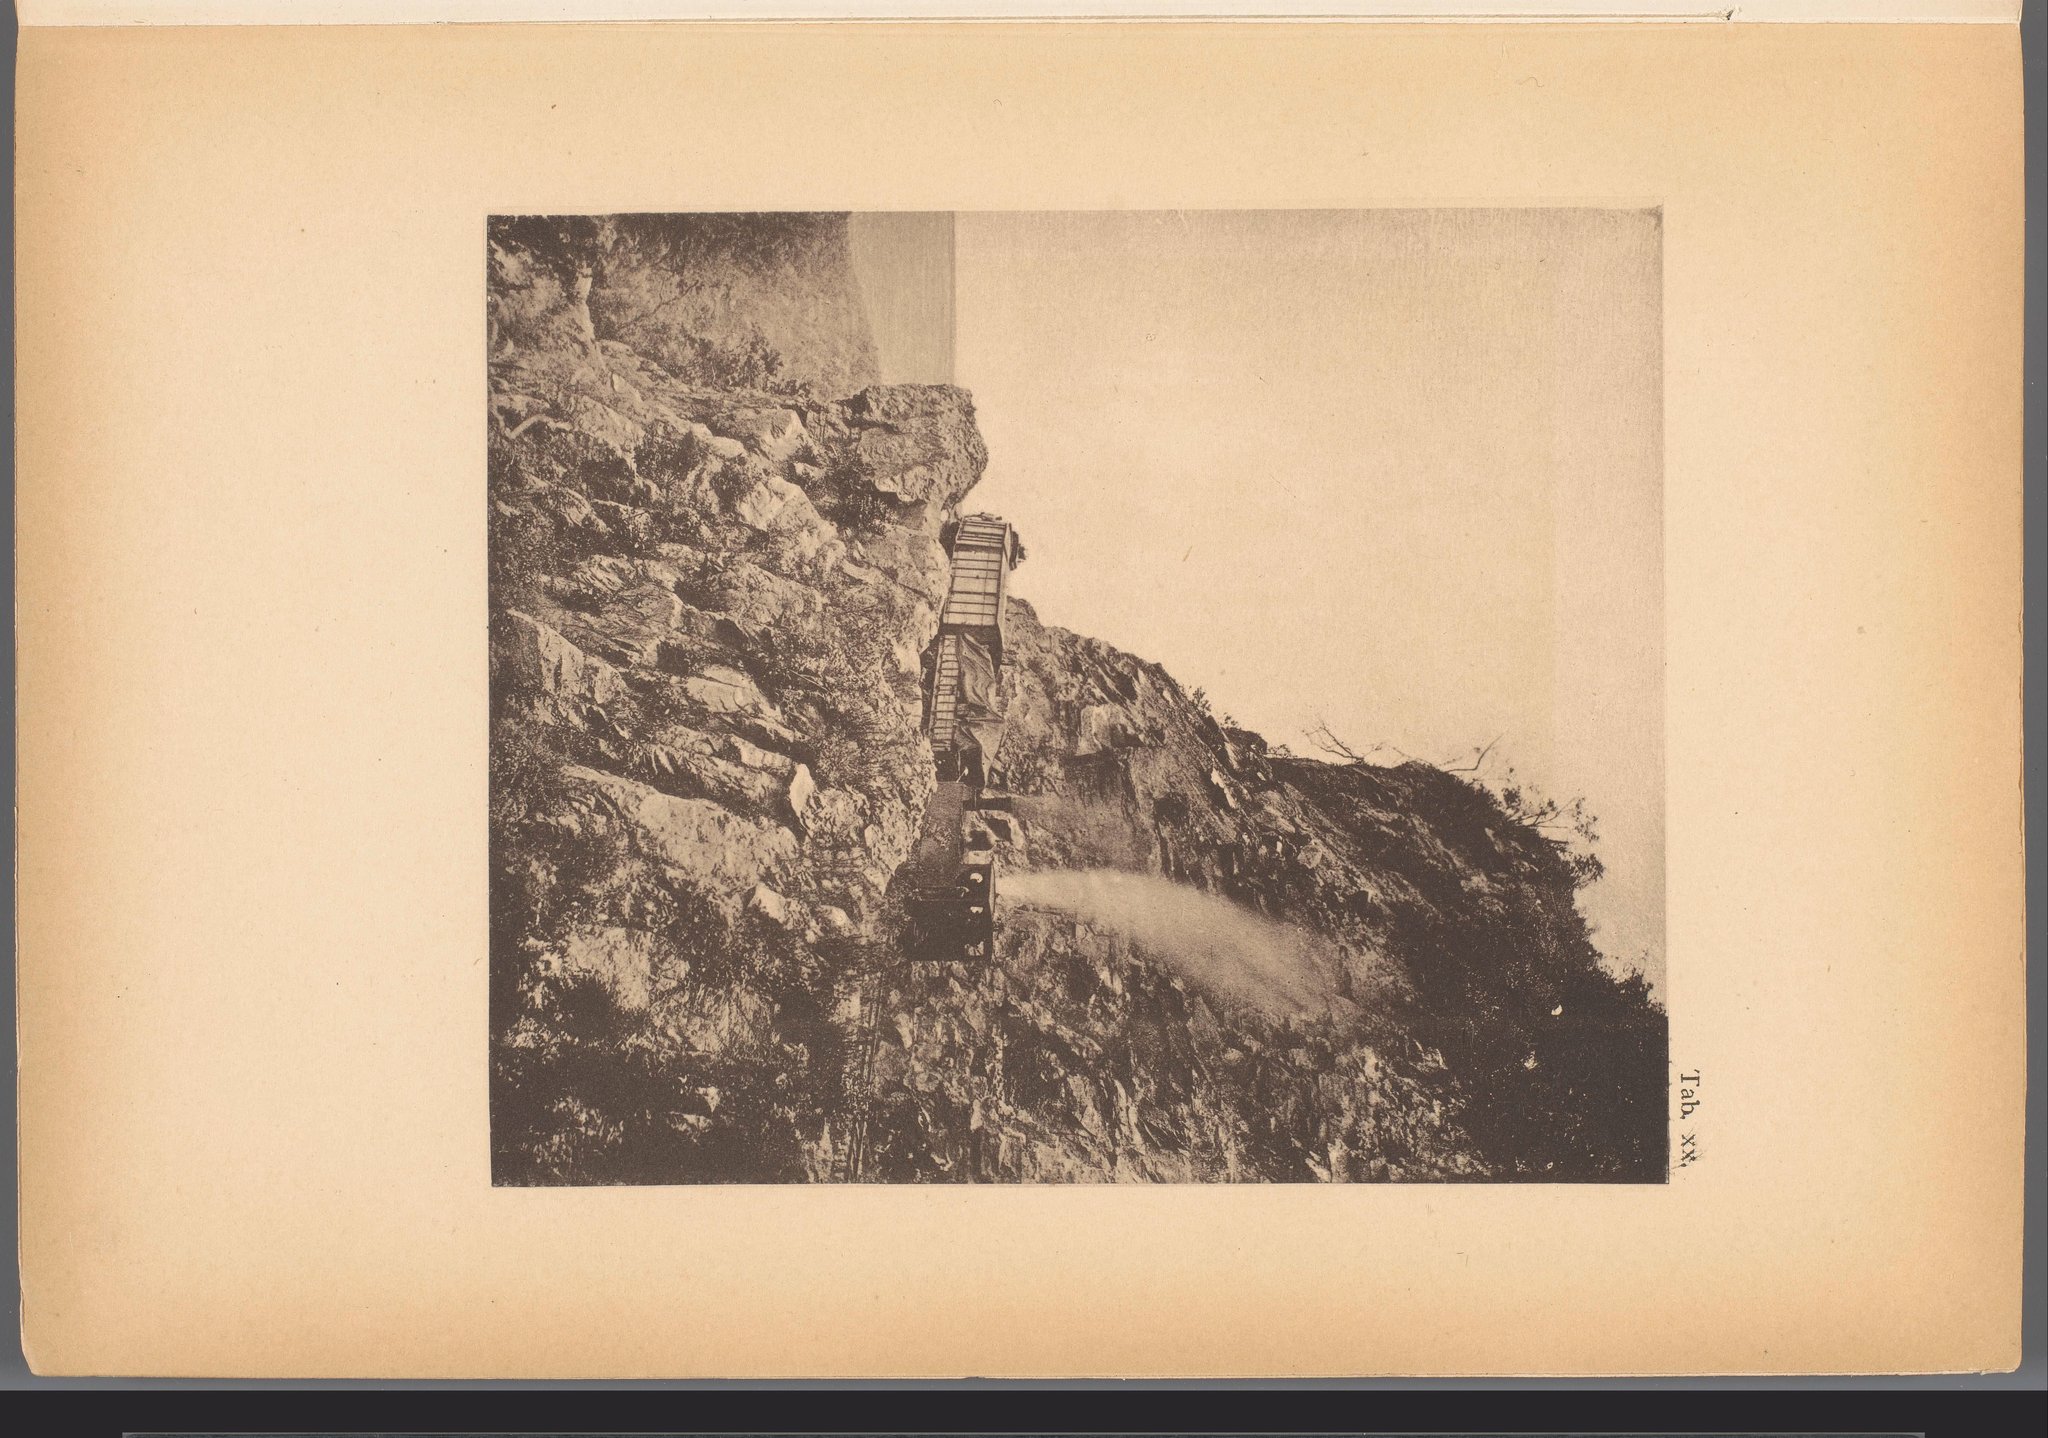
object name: page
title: Gezicht op een stoomtrein op het spoor tussen La Guaira en Caracas in Venezuela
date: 1877-1887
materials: paper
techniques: photograph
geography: venezuela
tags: railway, train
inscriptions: number: ‘Tab. XX.’